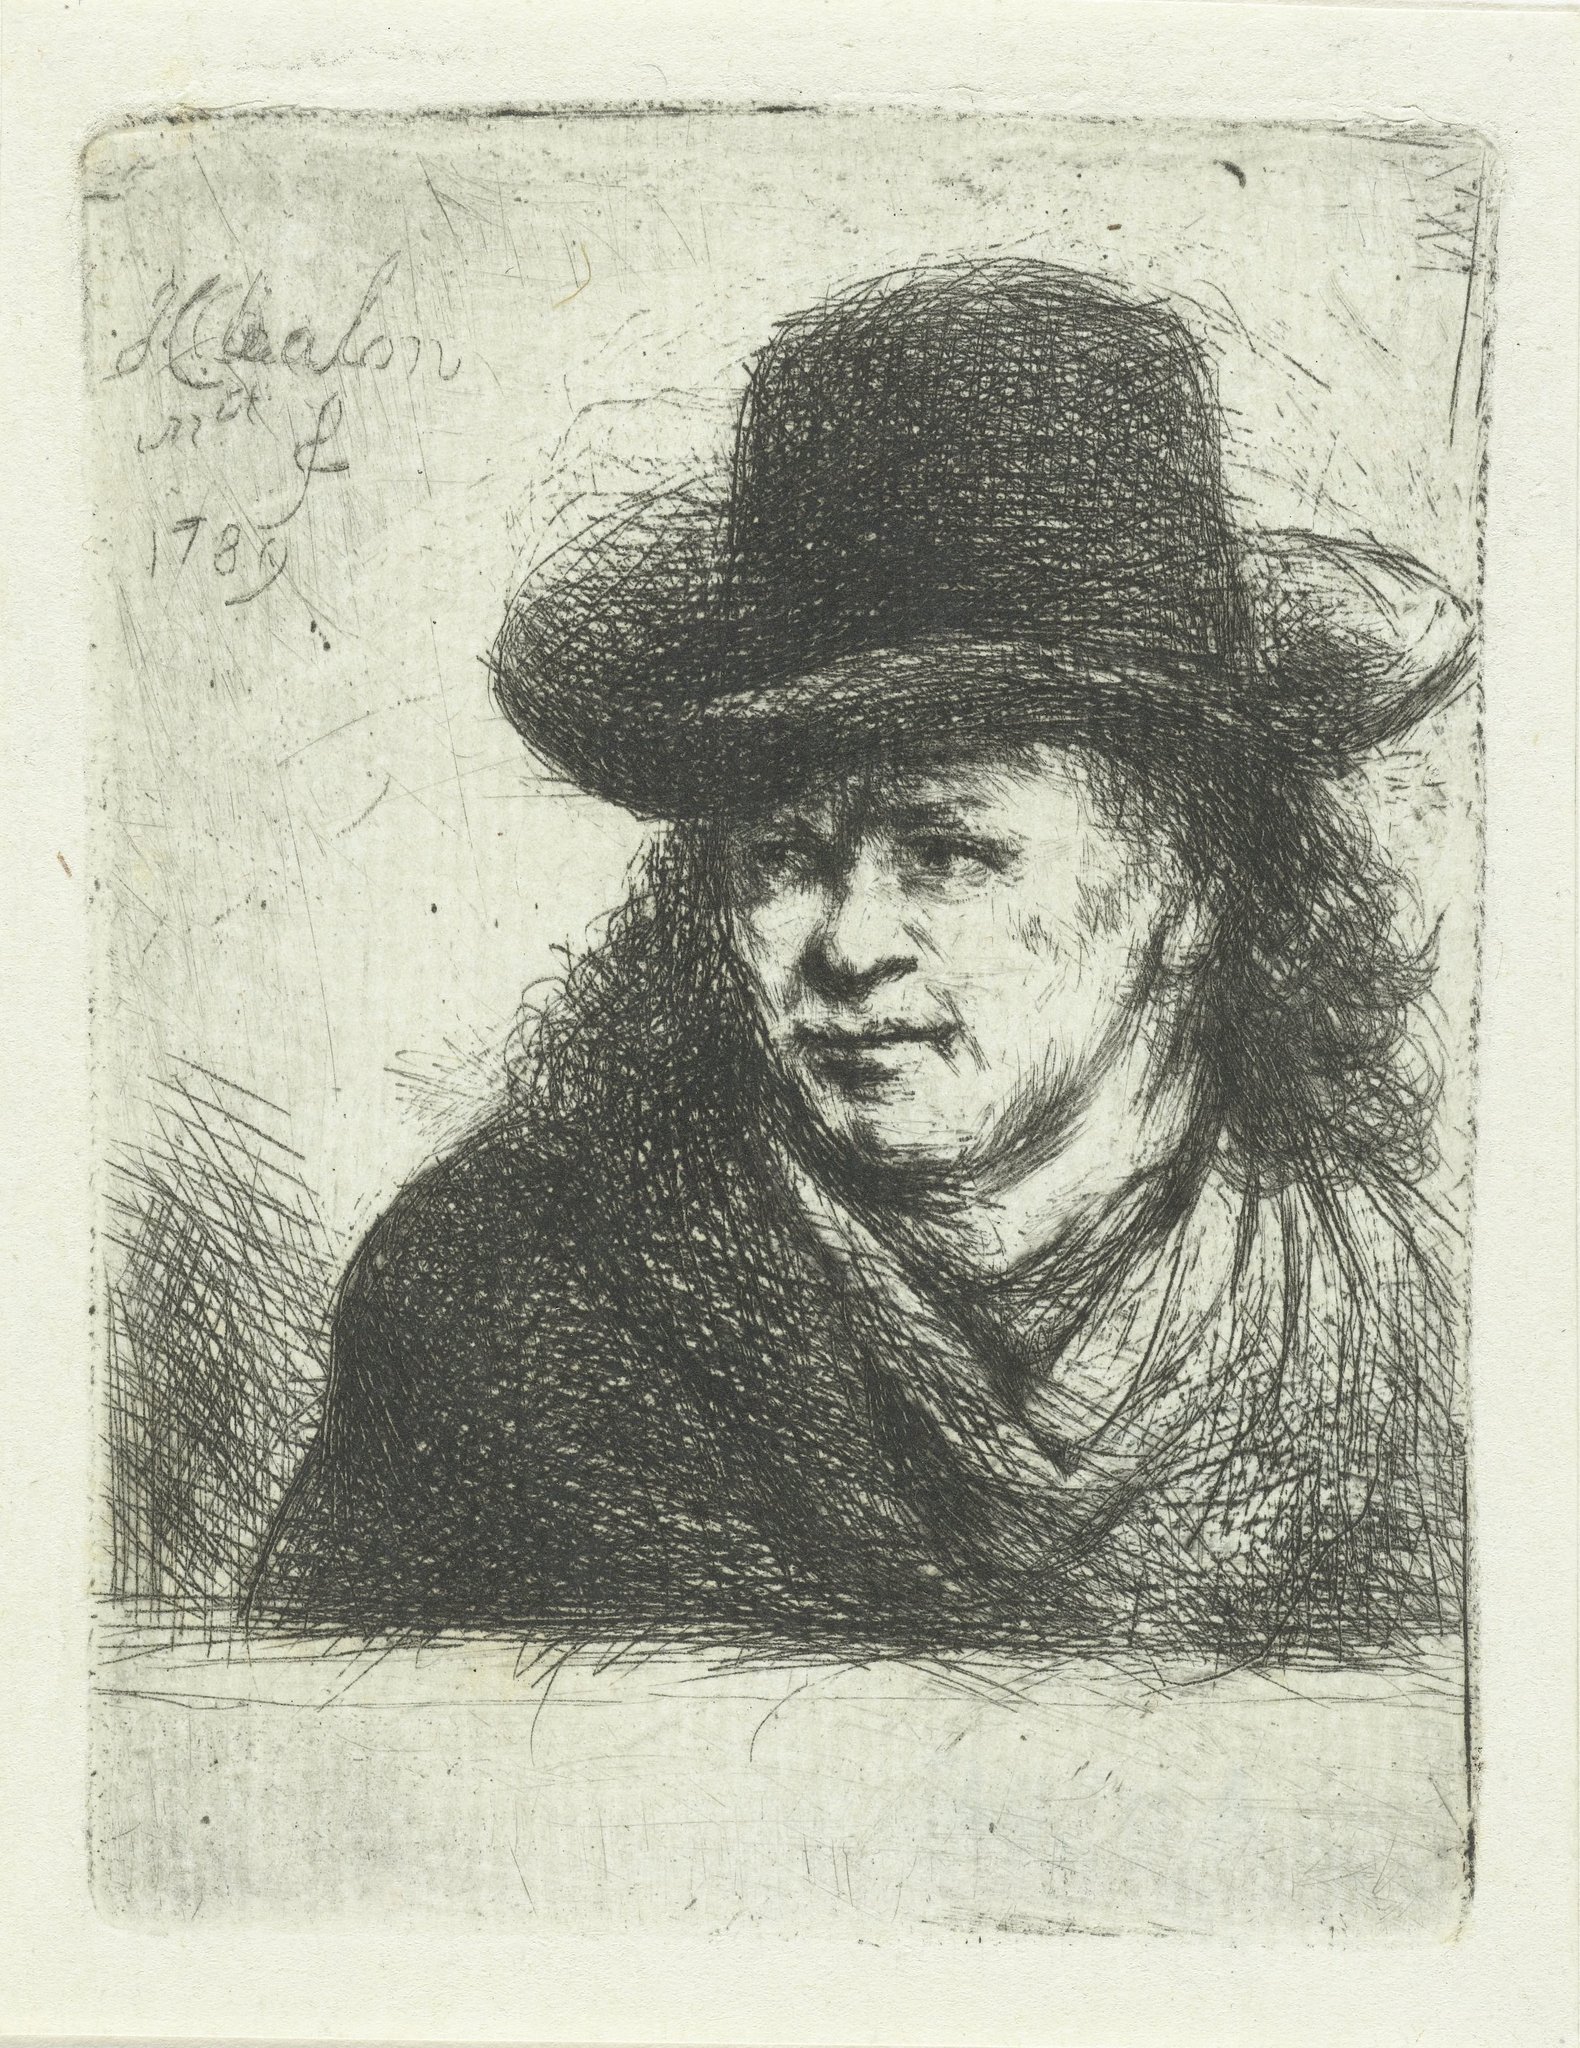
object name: print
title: Man met hoed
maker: jan chalon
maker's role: print maker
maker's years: 1738-1795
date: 1789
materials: paper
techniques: drypoint, etching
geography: northern netherlands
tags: head-gear: hat (+ men's clothes), morphology of human expression (+ adult male (human being))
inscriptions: date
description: Een volwassen man met hoed. Buste naar links.